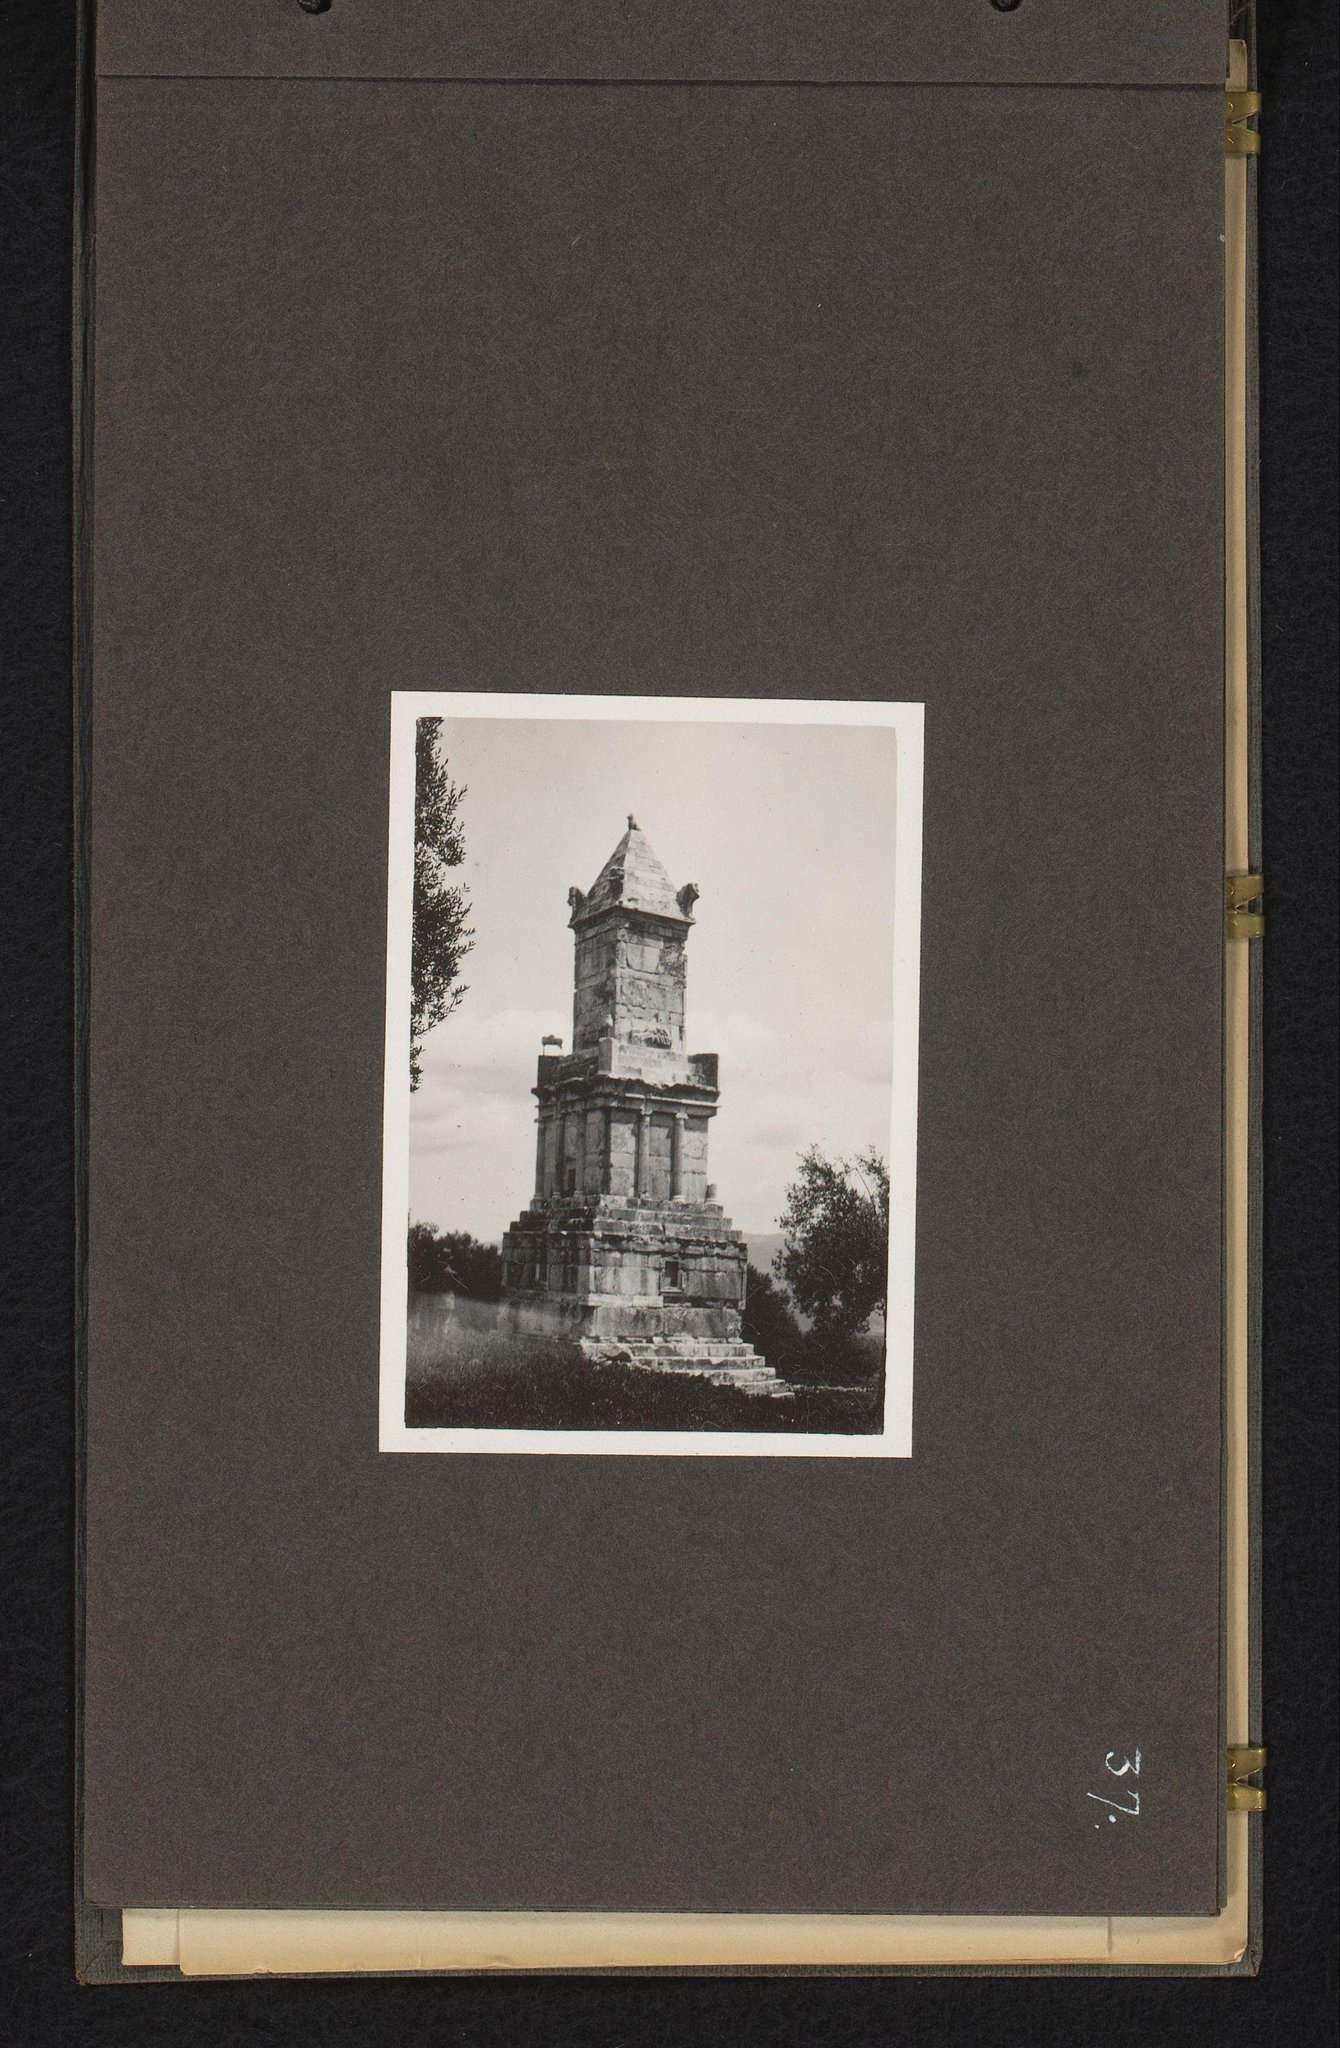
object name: album leaf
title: Lybisch-Punisch mausoleum.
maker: a.g.a. van eelde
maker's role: engineer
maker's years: 1862-1950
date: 1927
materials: paper, photographic support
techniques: gelatin silver print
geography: dougga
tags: landscape with ruins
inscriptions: number: ‘37.’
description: Titel 'Lybisch-Punisch mausoleum.' afkomstig uit de inventaris achterin het album.